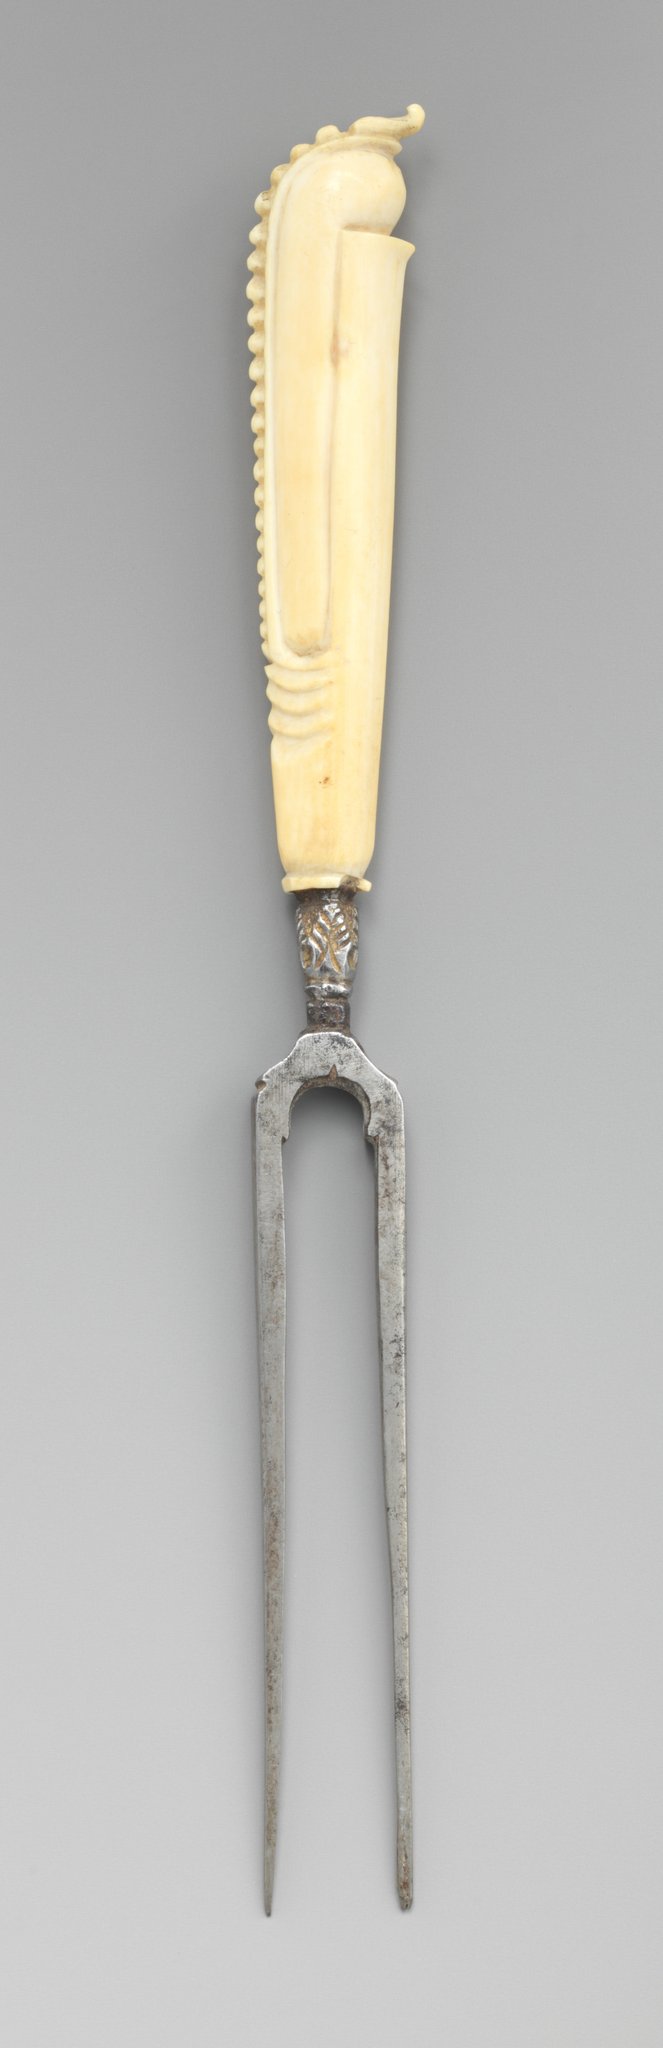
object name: table fork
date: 1601-1700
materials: ivory, steel